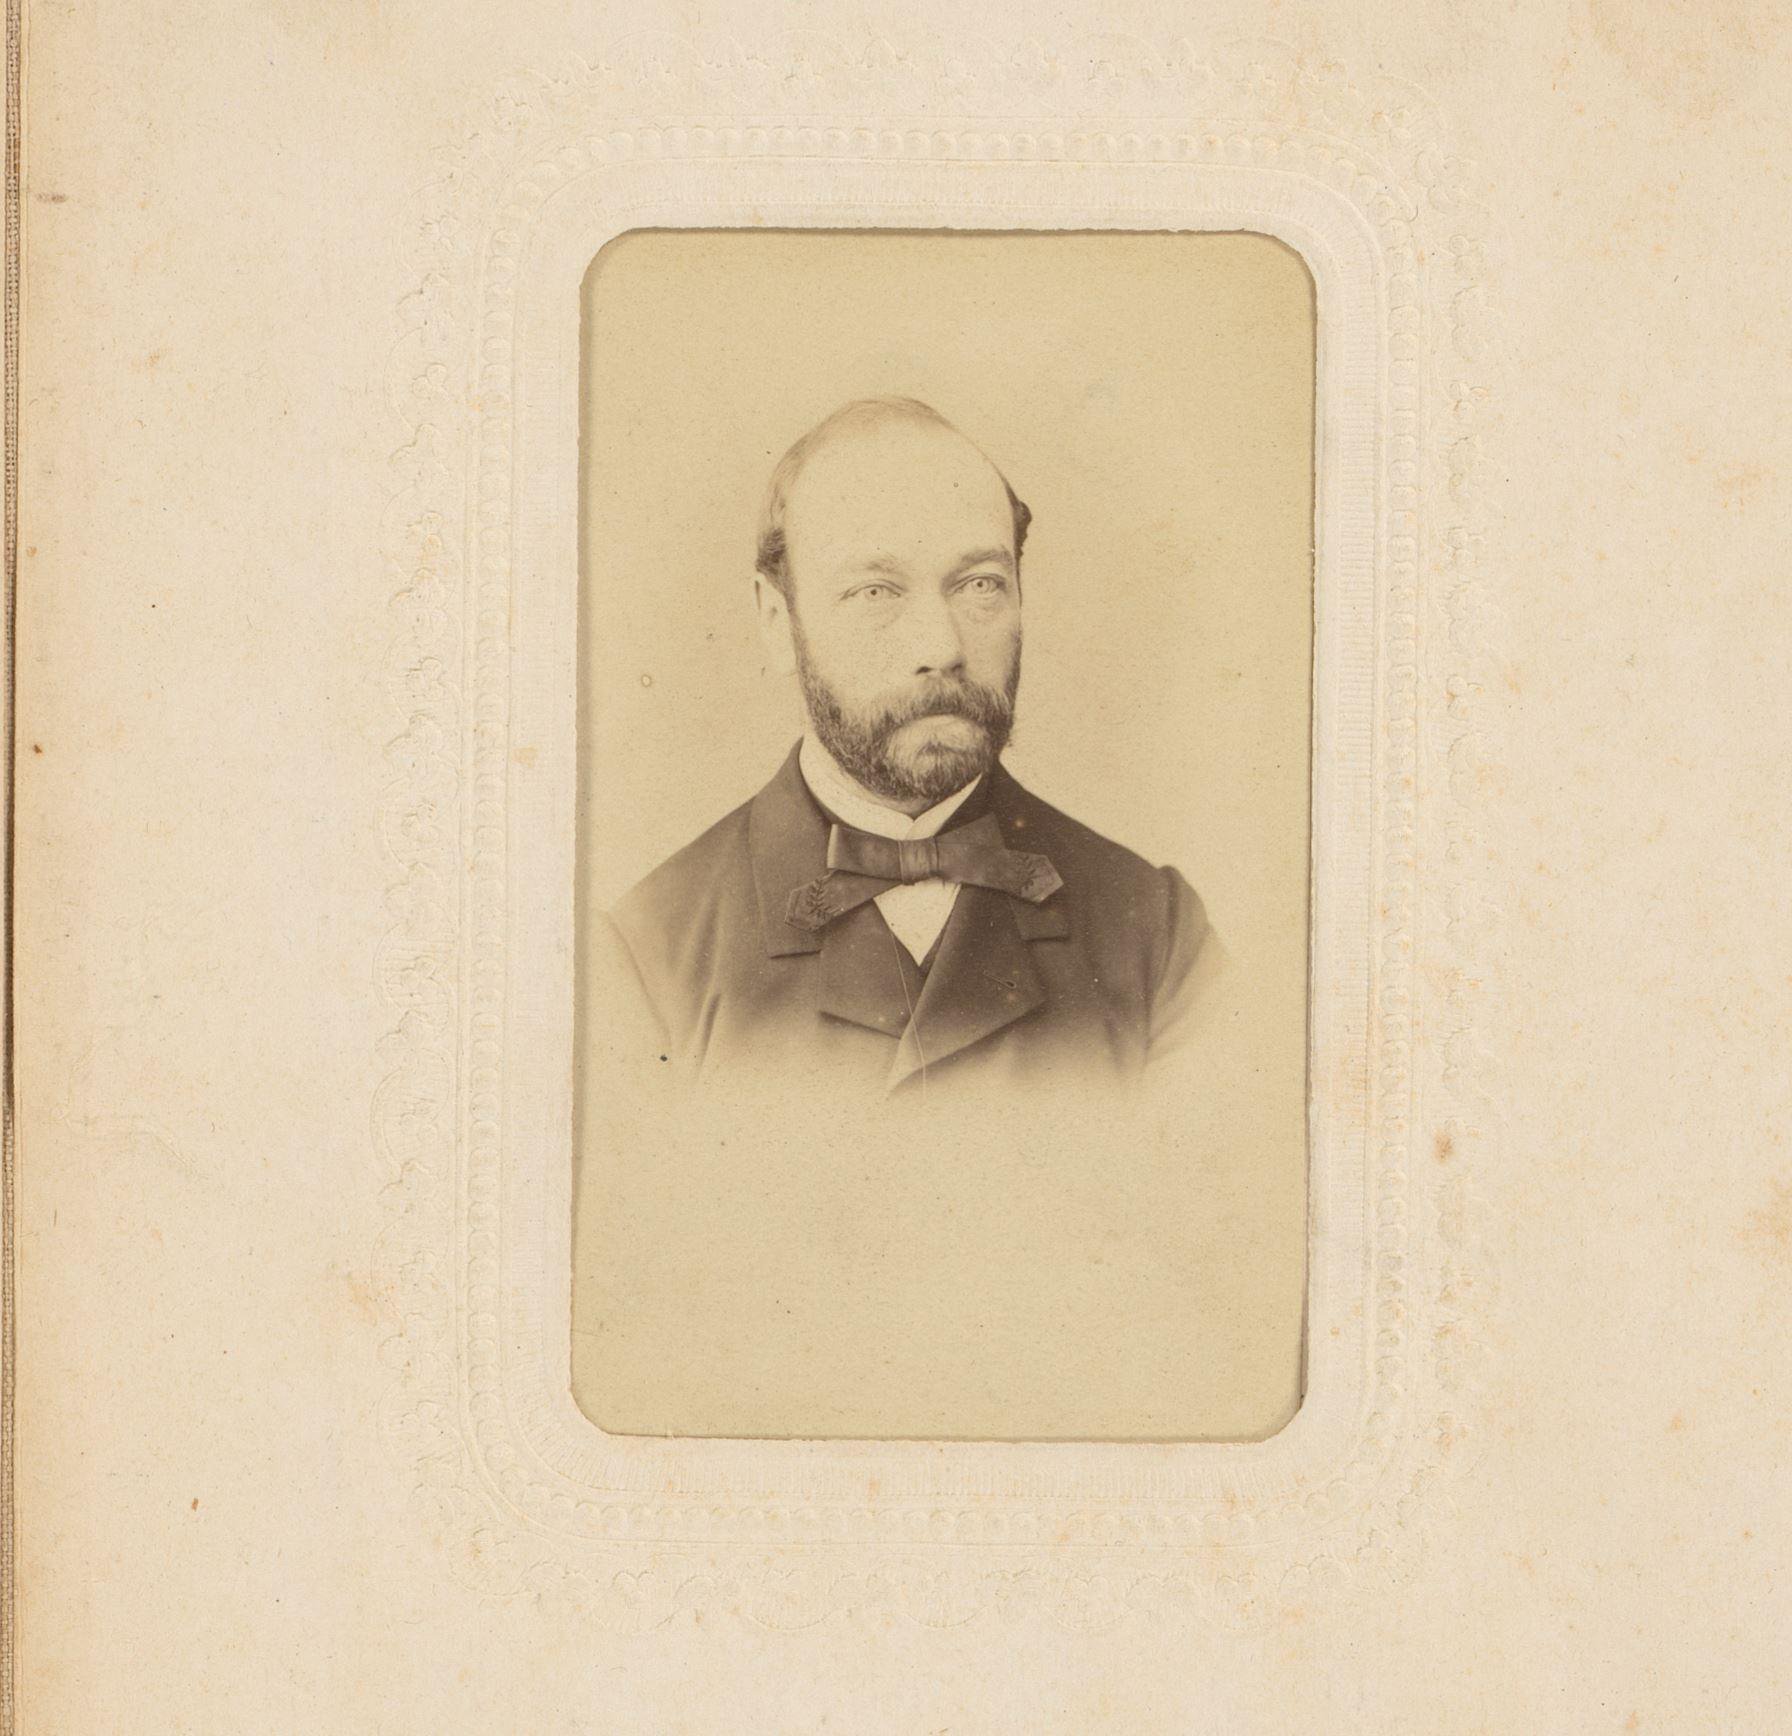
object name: carte de visite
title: Portret van een man met baard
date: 1862-1863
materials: cardboard, photographic support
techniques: albumen print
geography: brussels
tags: historical persons, beard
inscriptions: inscription: ‘Etablissement Photographique/ de Maes & Michaux/ Place de la Monnaie, 36, Rue Fossé-aux-Loups/ Bruxelles’